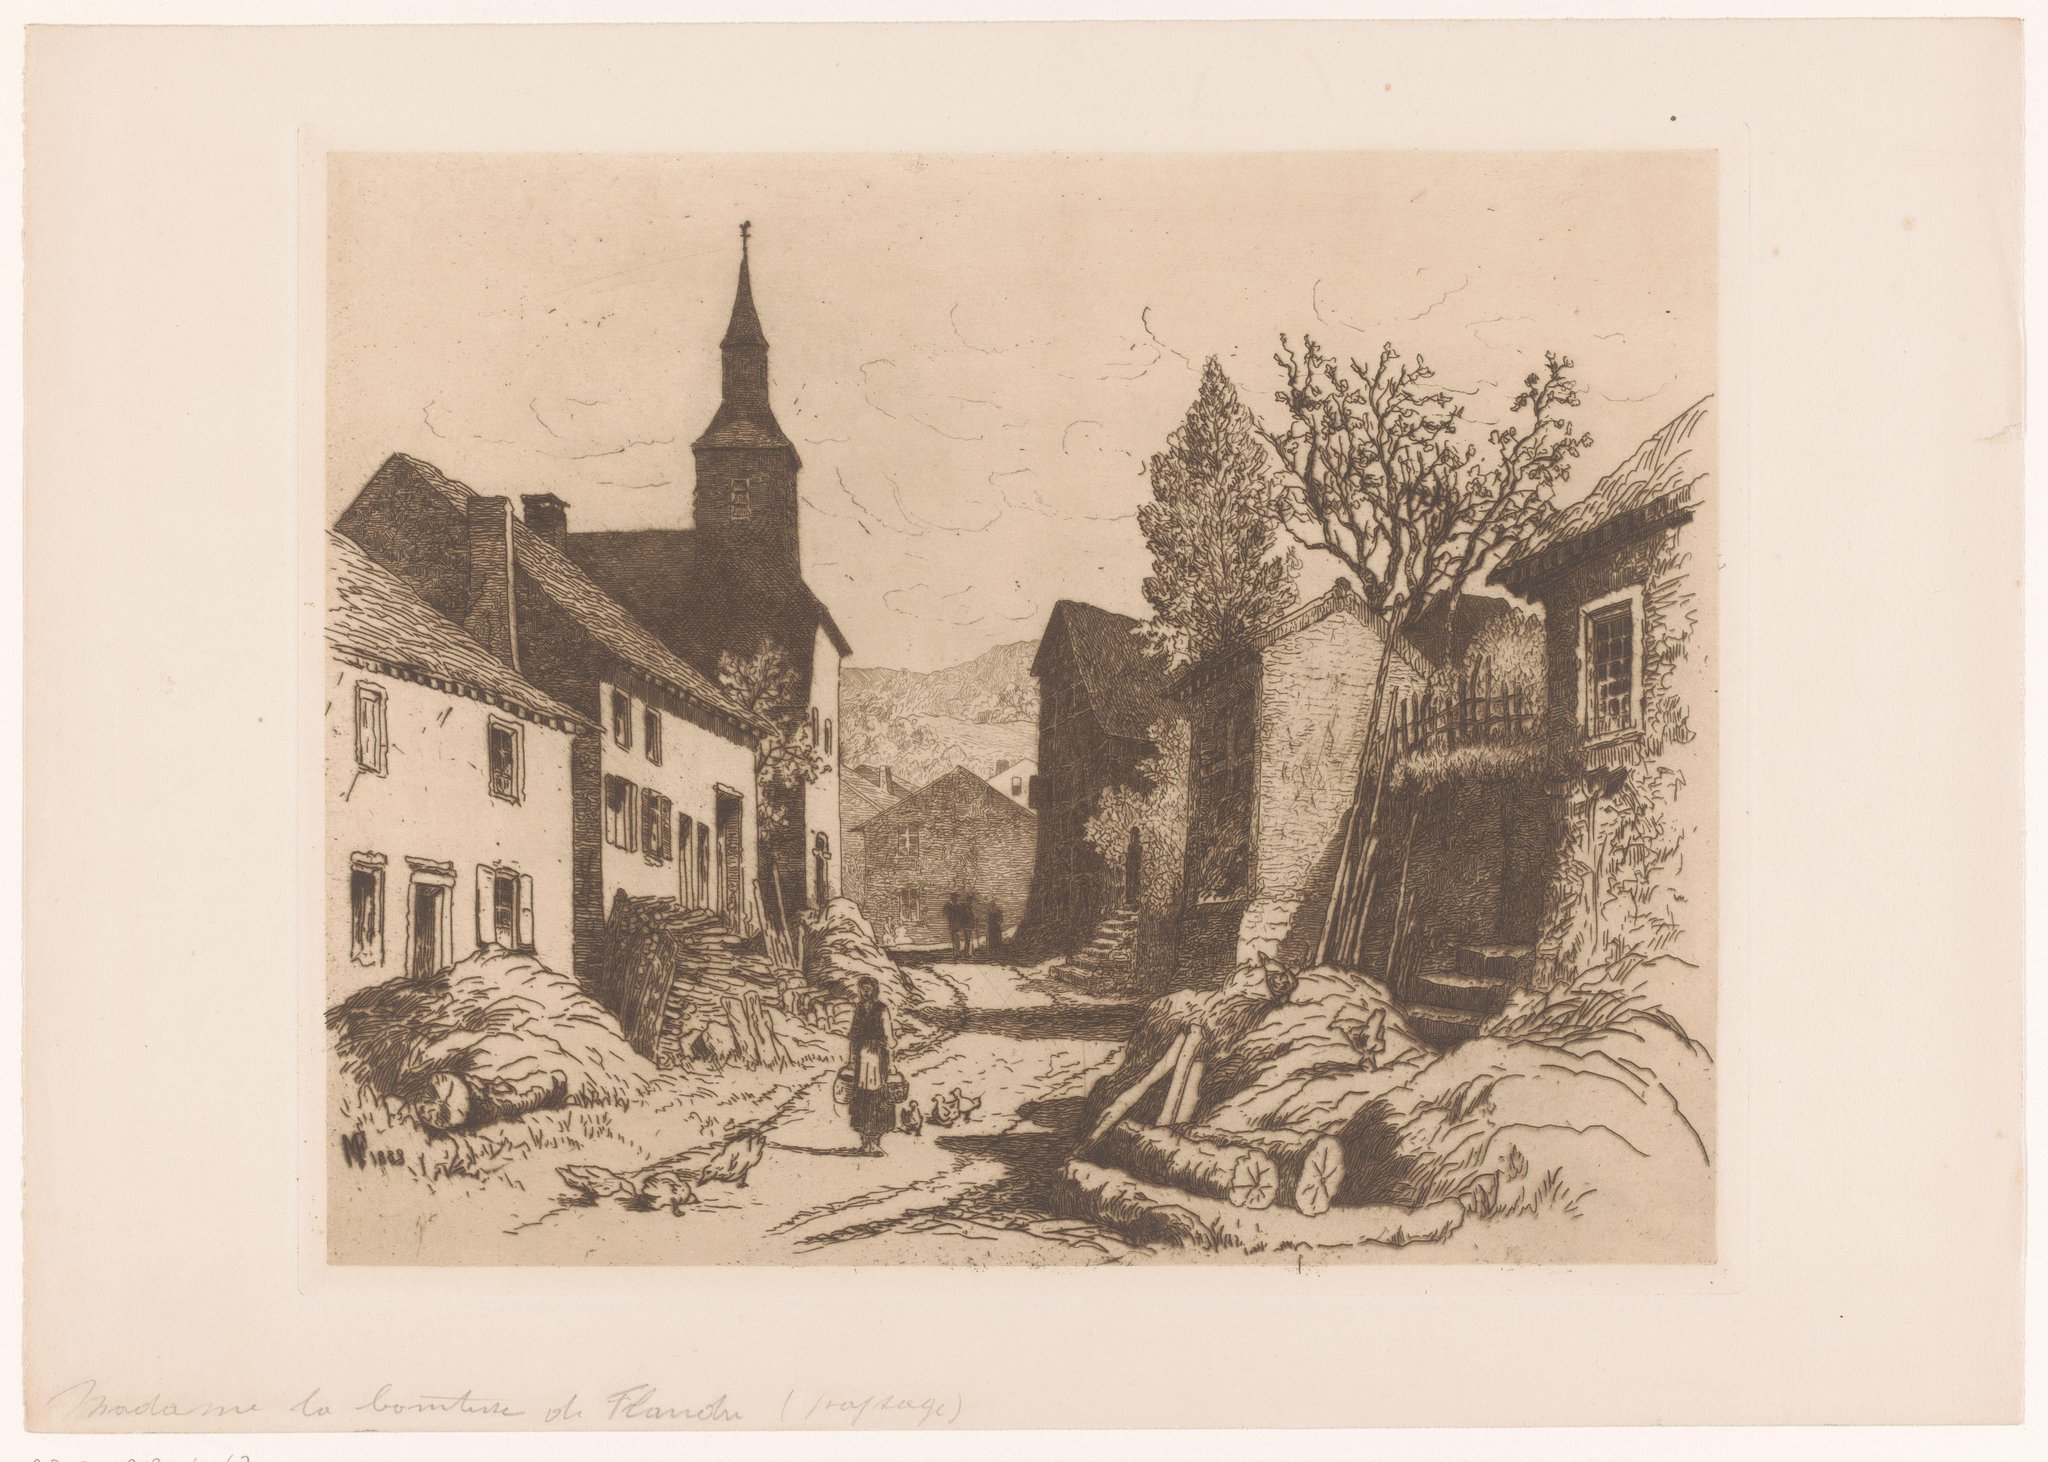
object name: print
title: Gezicht op een straat in een bergdorp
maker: maria van hohenzollern-sigmaringen (gravin van vlaanderen)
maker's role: print maker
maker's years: 1845-1912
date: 1883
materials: paper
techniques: drypoint, etching, intaglio, retroussage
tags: village street, mountains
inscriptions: annotation: ‘Madame la Comtesse de Flandres (postage)’, collector's mark: Lugt 2228